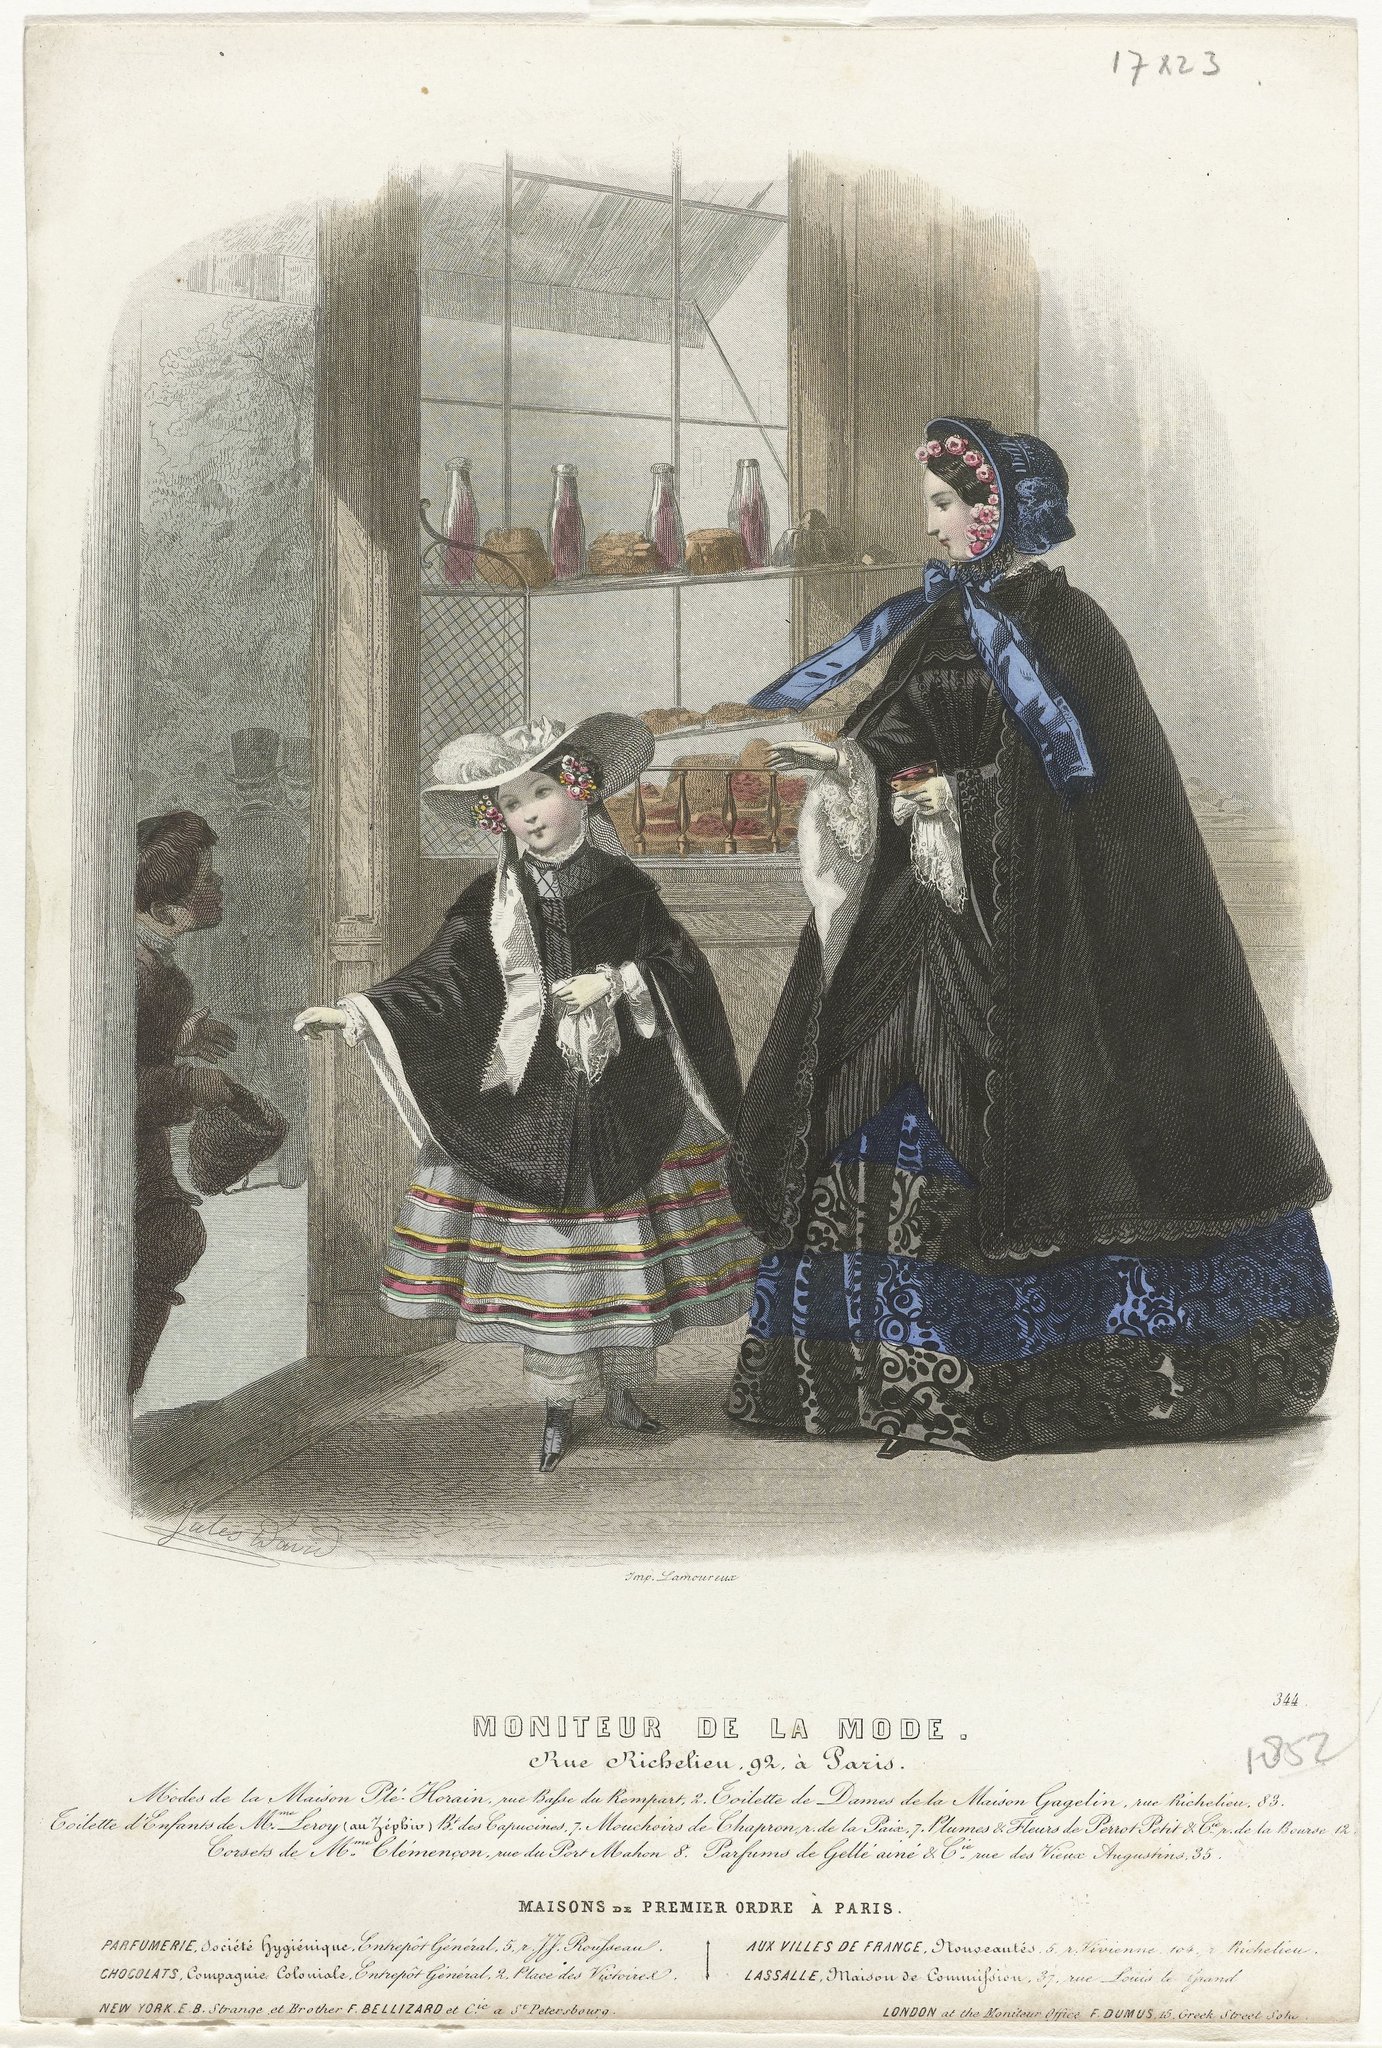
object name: fashion print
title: Le Moniteur de la mode, 1852, No. 344 : Modes de la Maison (...)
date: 1852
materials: paper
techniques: hand coloring, engraving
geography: new york city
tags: shop, store, flowers, handkerchief (+ women's clothes), skirt (+ girls' clothes), head-gear: hat (+ girls' clothes), underclothes for the lower part of the body: bloomers (+ girls' clothes), coat (+ women's clothes), cape (+ girls' clothes), fashion plates, head-gear: hat (+ women's clothes), gloves, mittens, etc. (+ women's clothes), beggar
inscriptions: address: ‘Rue Richelieu, 92, à Paris.’, title: ‘Moniteur de la Mode.’, caption: ‘Maisons de premier ordre à Paris / Parfumerie Societé Hygienique, Entrepôt Général, 5, r, J.J. Rousseau. / Chocolats, Compagnie Coloniale, Entrepôt Général, 2, Place des Victoires. / Aux Villes de France, Nouveautés, 5, r, Vivienne, 104, r, Richelieu. Lassalle, Maison de Commission, 37, rue Louis le Grand’, caption: ‘Modes de la Maison Plé-Horain, rue Basse du Rompart, 2. Toilette de Dames de la Maison Gagelin, rue Richelieu, 83. Toilette d'Enfants de M'me Leroy (au Zéphir) B"t des Capucines, 7, Mouchoirs de Chapron, r, de la Paix, 7, Plumes & Fleurs de perrot Petit & C"ie r. de la Bourse 12. Corsets de M"me Clémençon, rue du Port Mahon 8, Parfums de Gellé ainé & C"ie rue des Vieux Augustins, 35.’, address: ‘New-York. E.B. Strange et Brother. F. Bellizard et C.ie à S.t Pétersbourg. / London at the Moniteur Office. F. Dumus 15 Greek Street Soho.’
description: Een vrouw en een meisje in een winkel. Het meisje geeft een muntstuk aan een bedelaar. Volgens het onderschrift: 'modes' van Plé-Horain. Vrouw in 'toilette' van Maison Gagelin. Kinderkleding van Leroy, 'au Zéphyr'. Hieronder enkele regels reclametekst voor verschillende producten. Prent uit het modetijdschrift Le Moniteur de la mode (1843-1913).